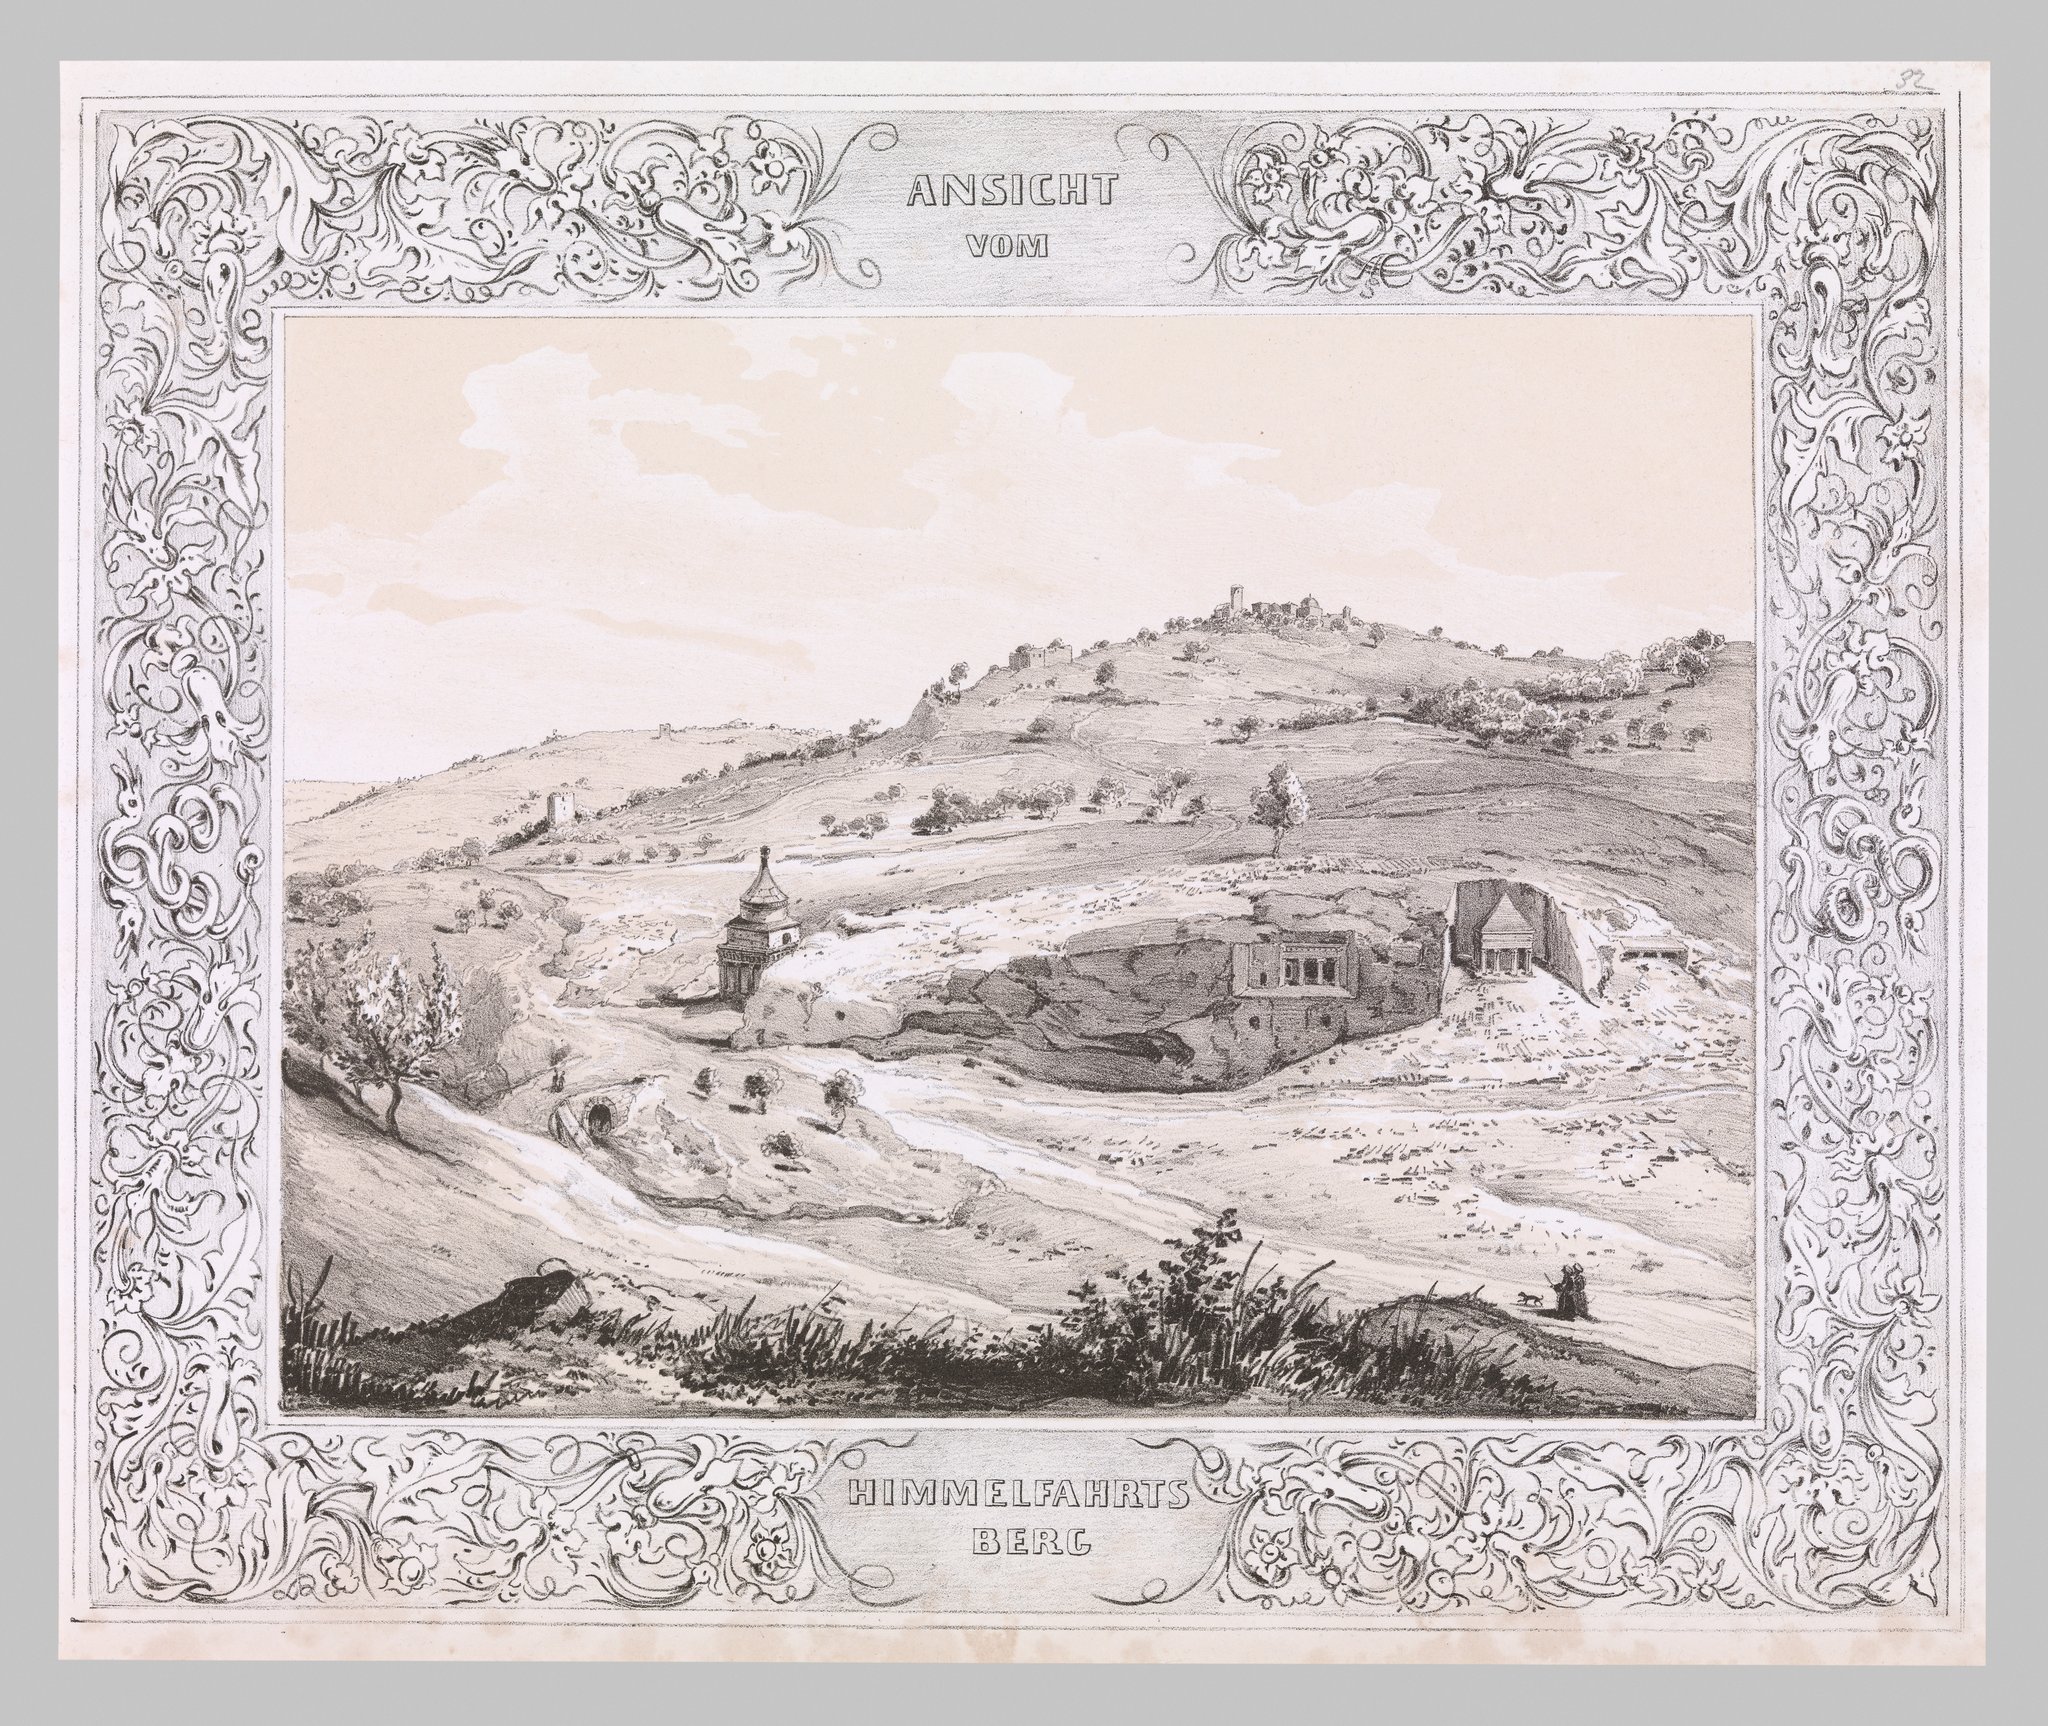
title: View of the Mount of Olives, from "Malerische Ansichten aus dem Orient..."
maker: heinrich von mayr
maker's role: artist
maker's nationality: german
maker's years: 1806-1871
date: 1839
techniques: lithograph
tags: landscapes